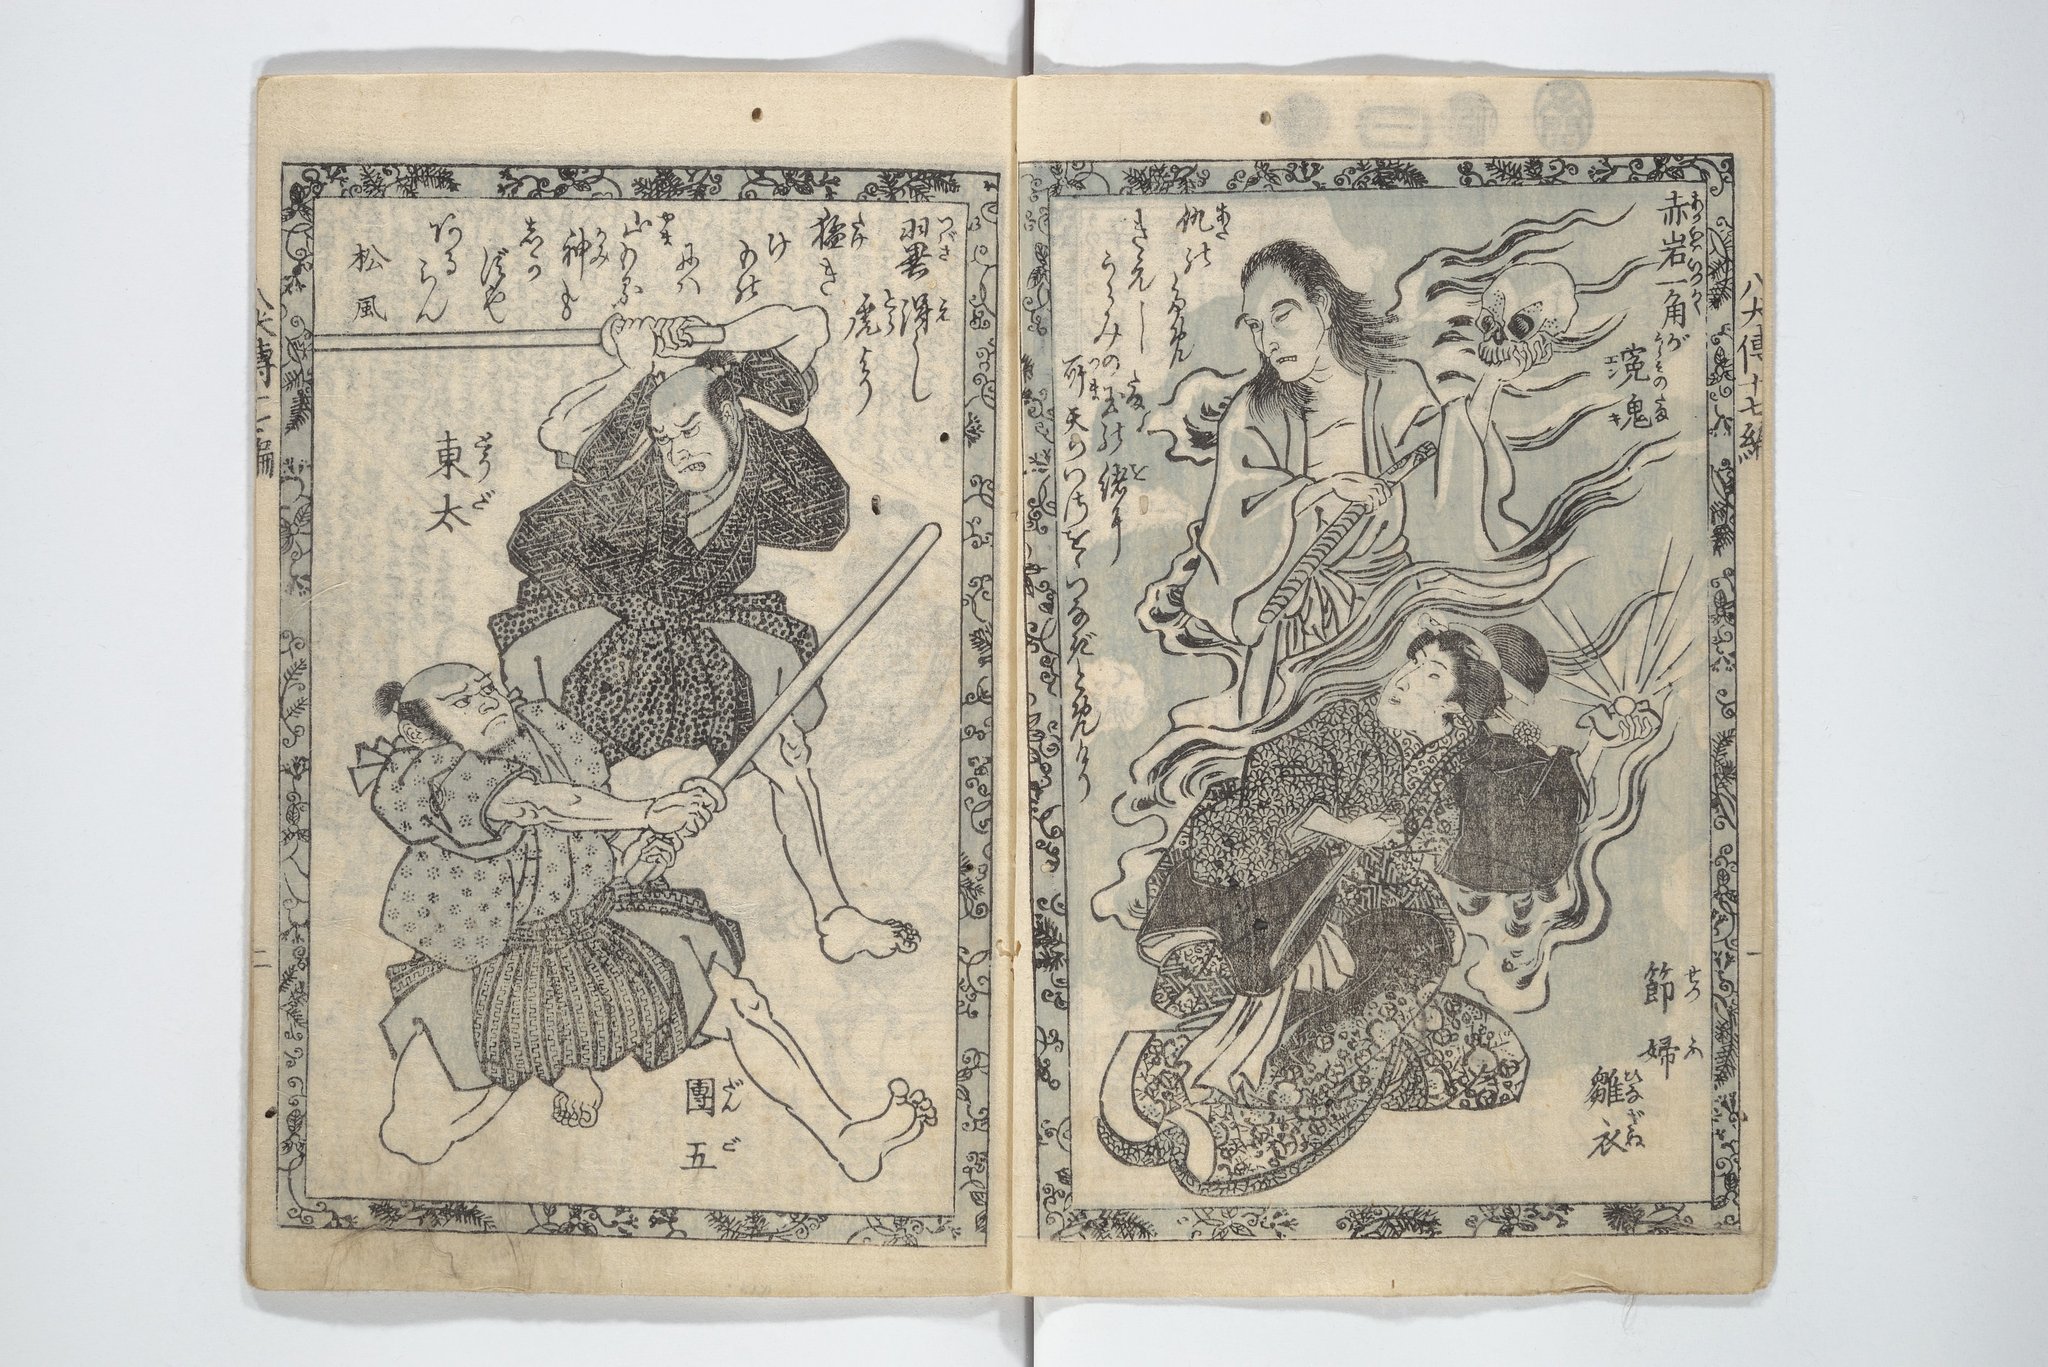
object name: illustrated book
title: Tale of Eight Dogs (Hakkenden) 八犬伝;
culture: japanese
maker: utagawa kuniyoshi 歌川國芳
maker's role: artist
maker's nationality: japanese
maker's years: 1797-1861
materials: ink, paper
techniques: woodblock print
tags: weapons,men,women